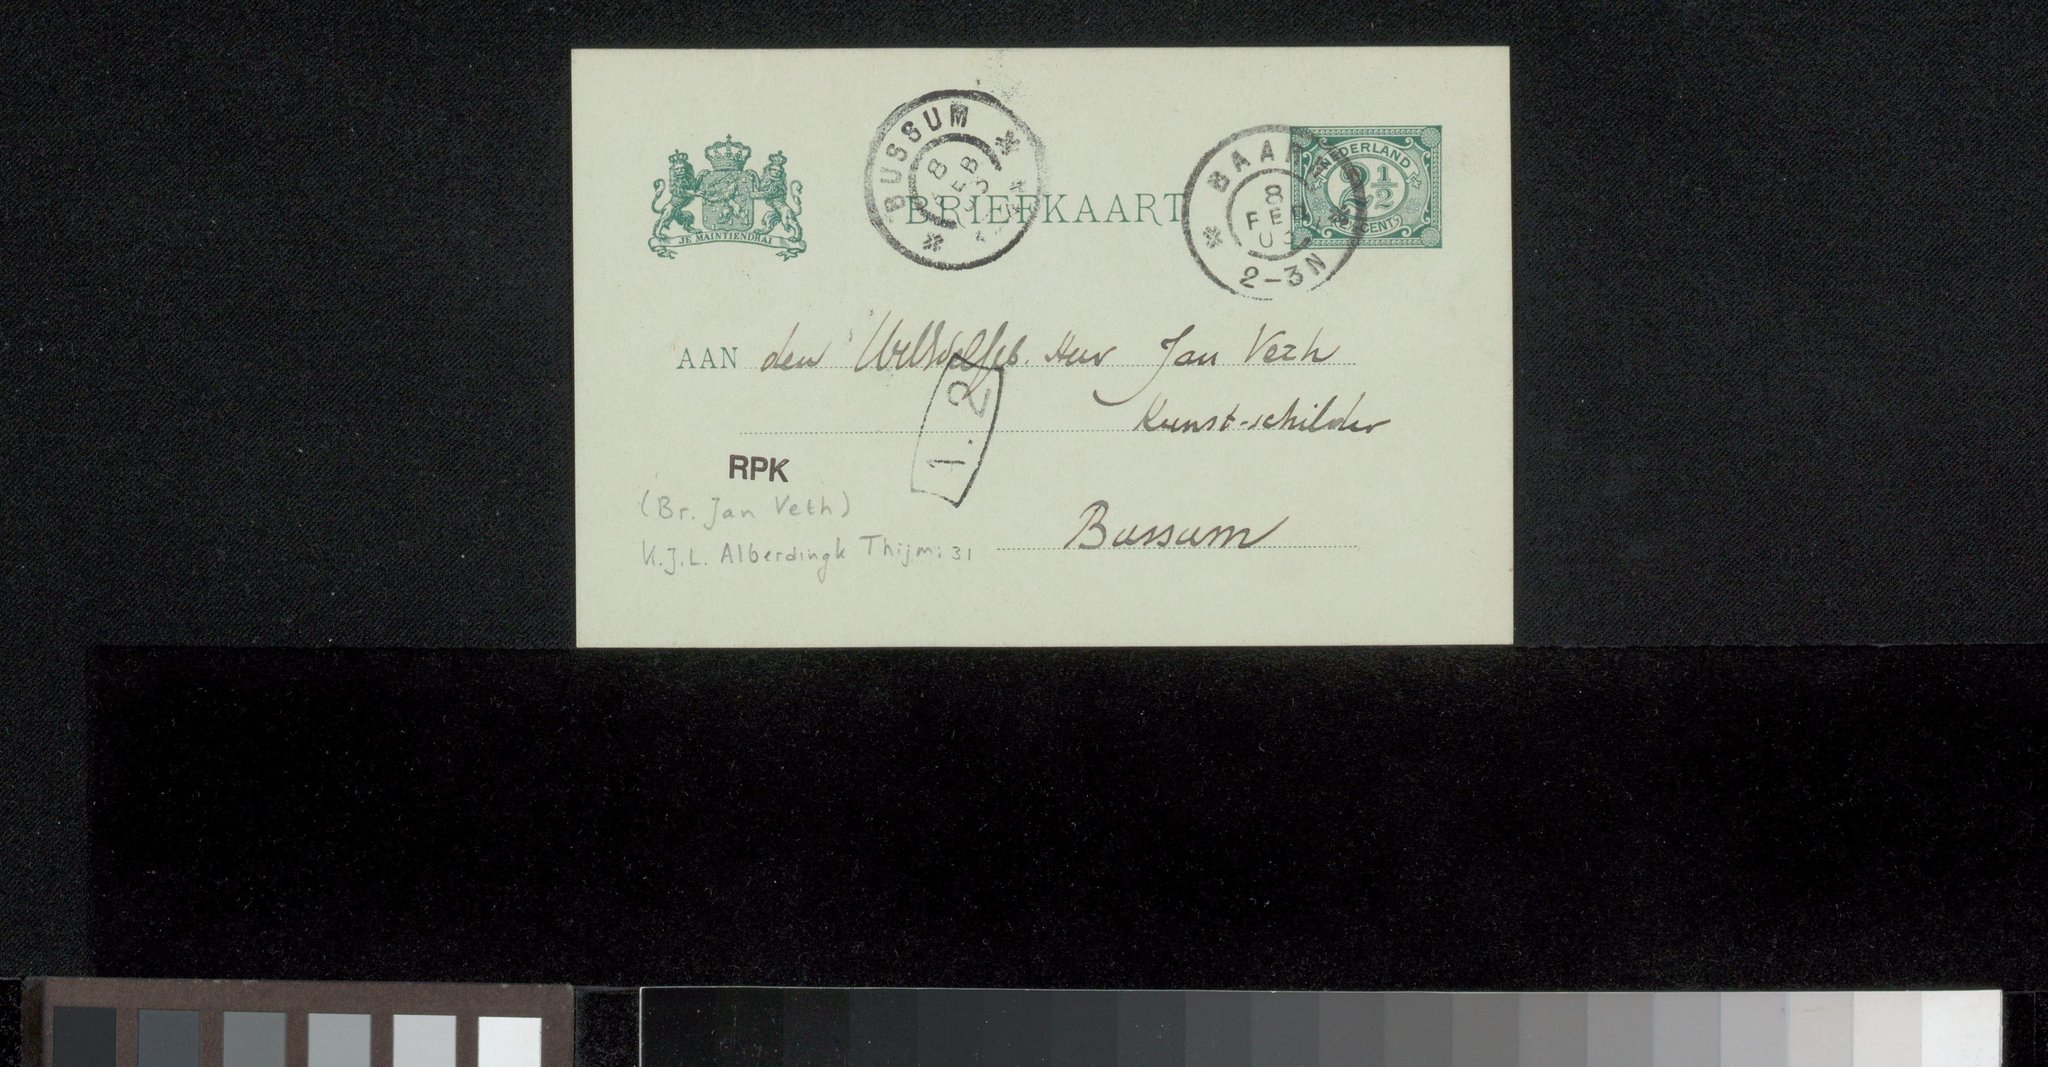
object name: postcard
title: Briefkaart aan Jan Veth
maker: karel johan lodewijk alberdingk thijm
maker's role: criticus, prozaschrijver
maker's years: 1864-1952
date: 1903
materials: cardboard, ink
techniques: pen, writing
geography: baarn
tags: dordrecht, amsterdam, painter, print maker, draughtsman, designer, jan veth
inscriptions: collector's mark: ‘RPK’